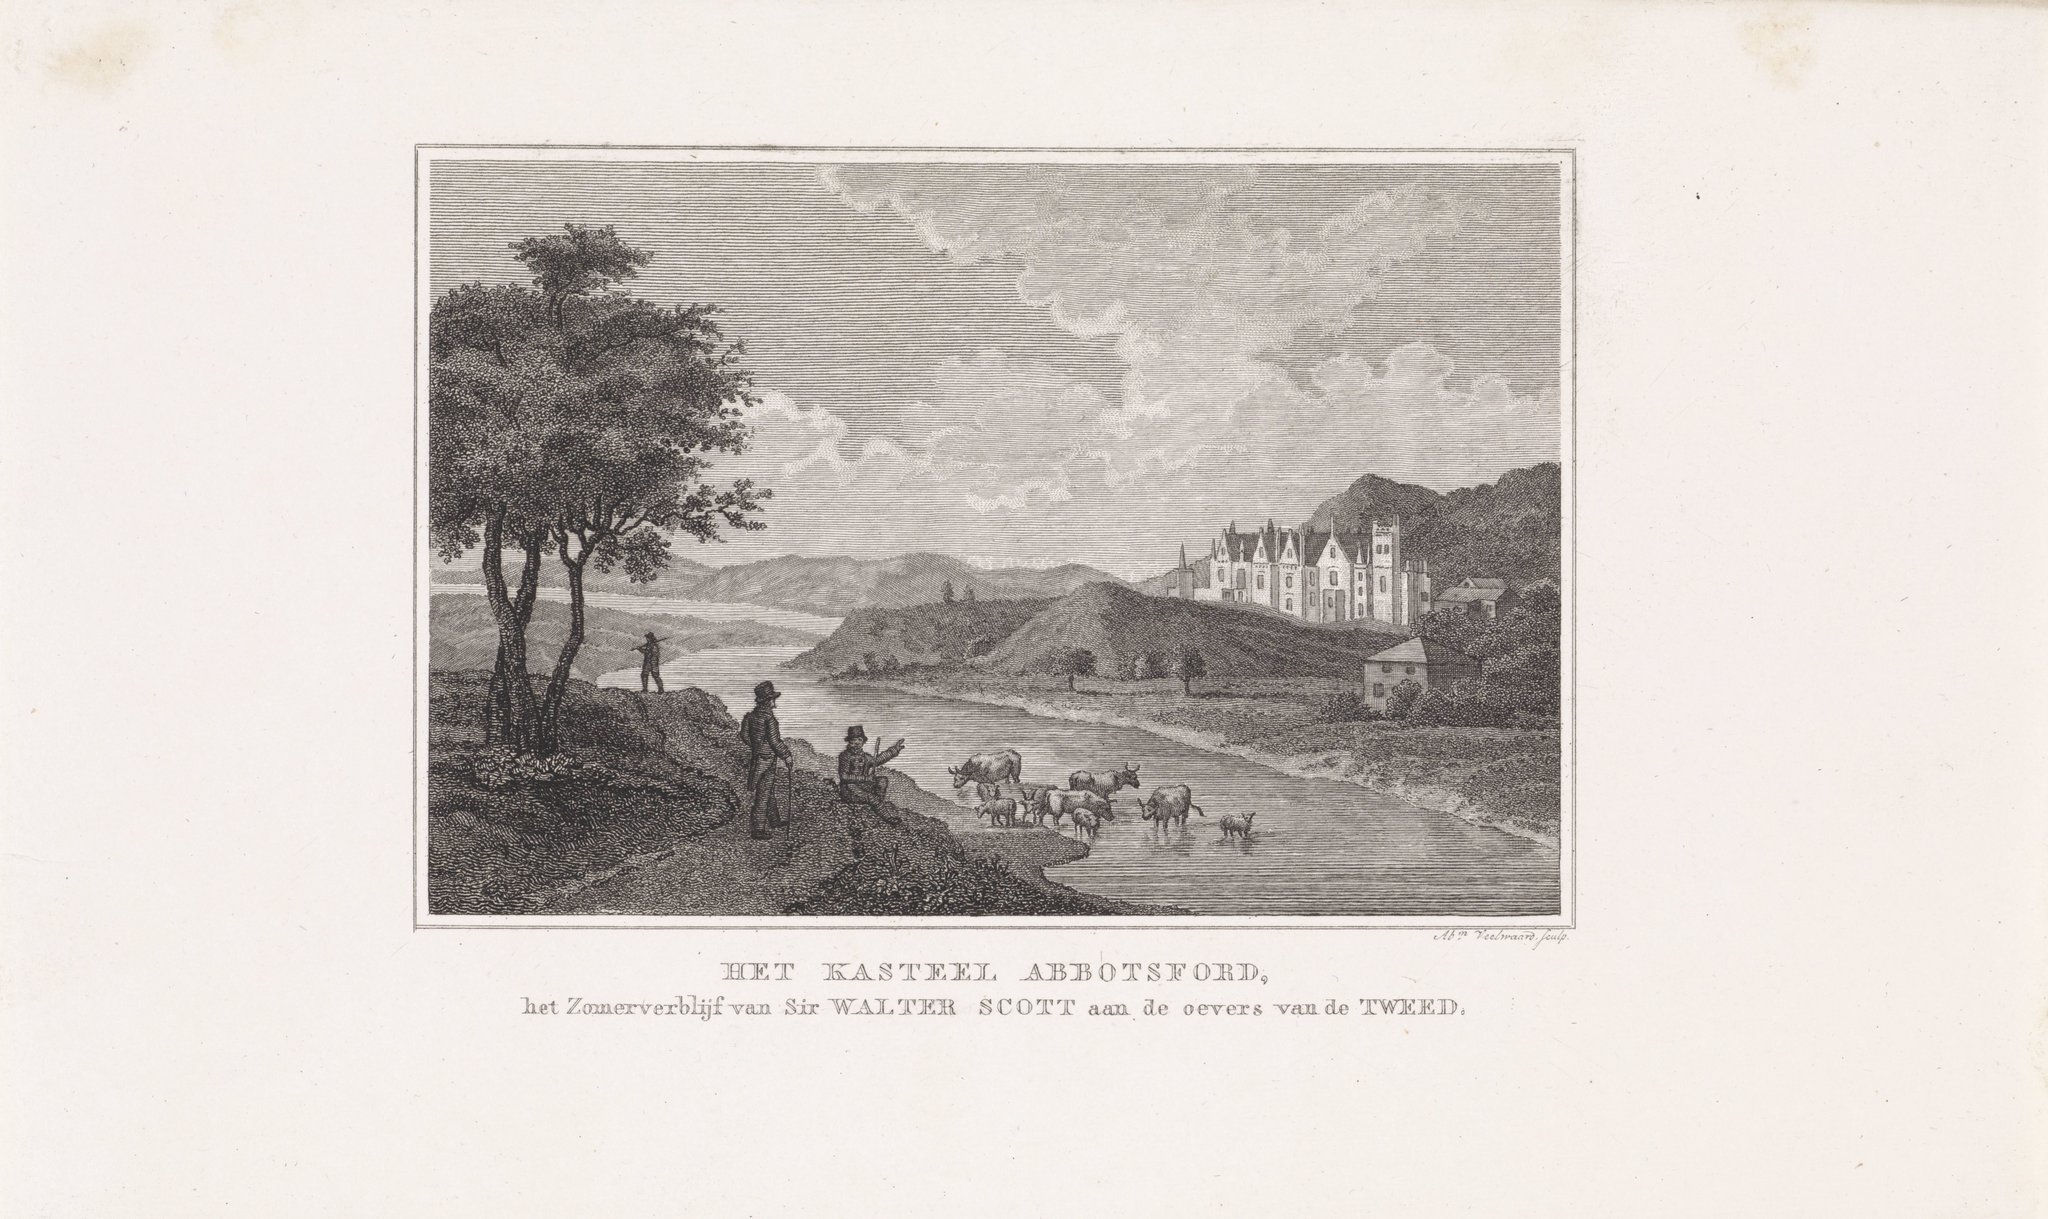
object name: print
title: Het kasteel Abbotsford, het Zomerverblijf van Sir Walter Scott aan de oevers van de Tweed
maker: abraham veelwaard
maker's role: print maker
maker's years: 1792-1873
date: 1802-1873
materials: paper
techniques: engraving, etching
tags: river, landscape with tower or castle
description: Deze prent is gebruikt in: Amédée Pichot, Geschied- en letterkundige reis naar Engeland en Schotland, deel 3, Haarlem 1826-1827